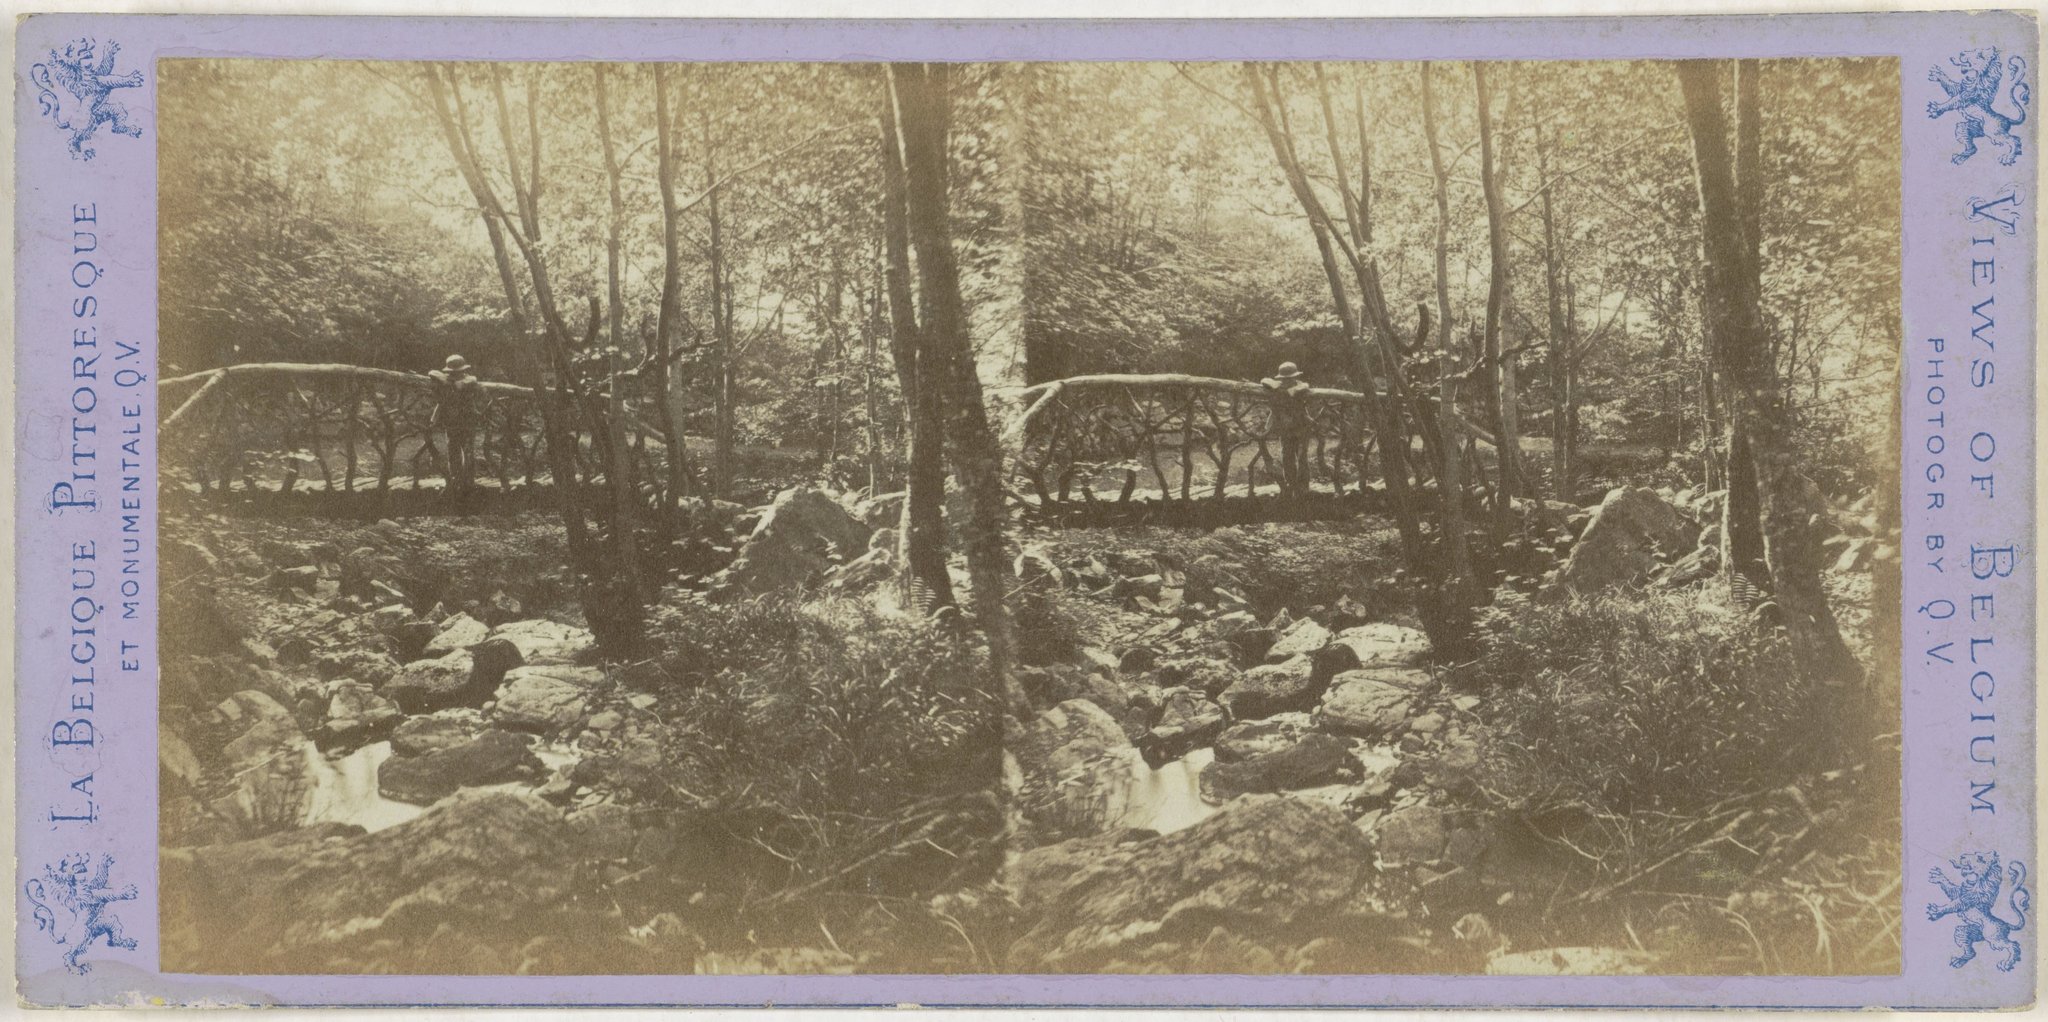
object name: stereograph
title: Spa, la promenade des artistes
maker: jules hippolyte quéval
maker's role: publisher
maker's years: 1824-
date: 1866-1870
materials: cardboard, paper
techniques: albumen print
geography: spa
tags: forest, wood, brook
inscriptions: number: ‘No 1790’